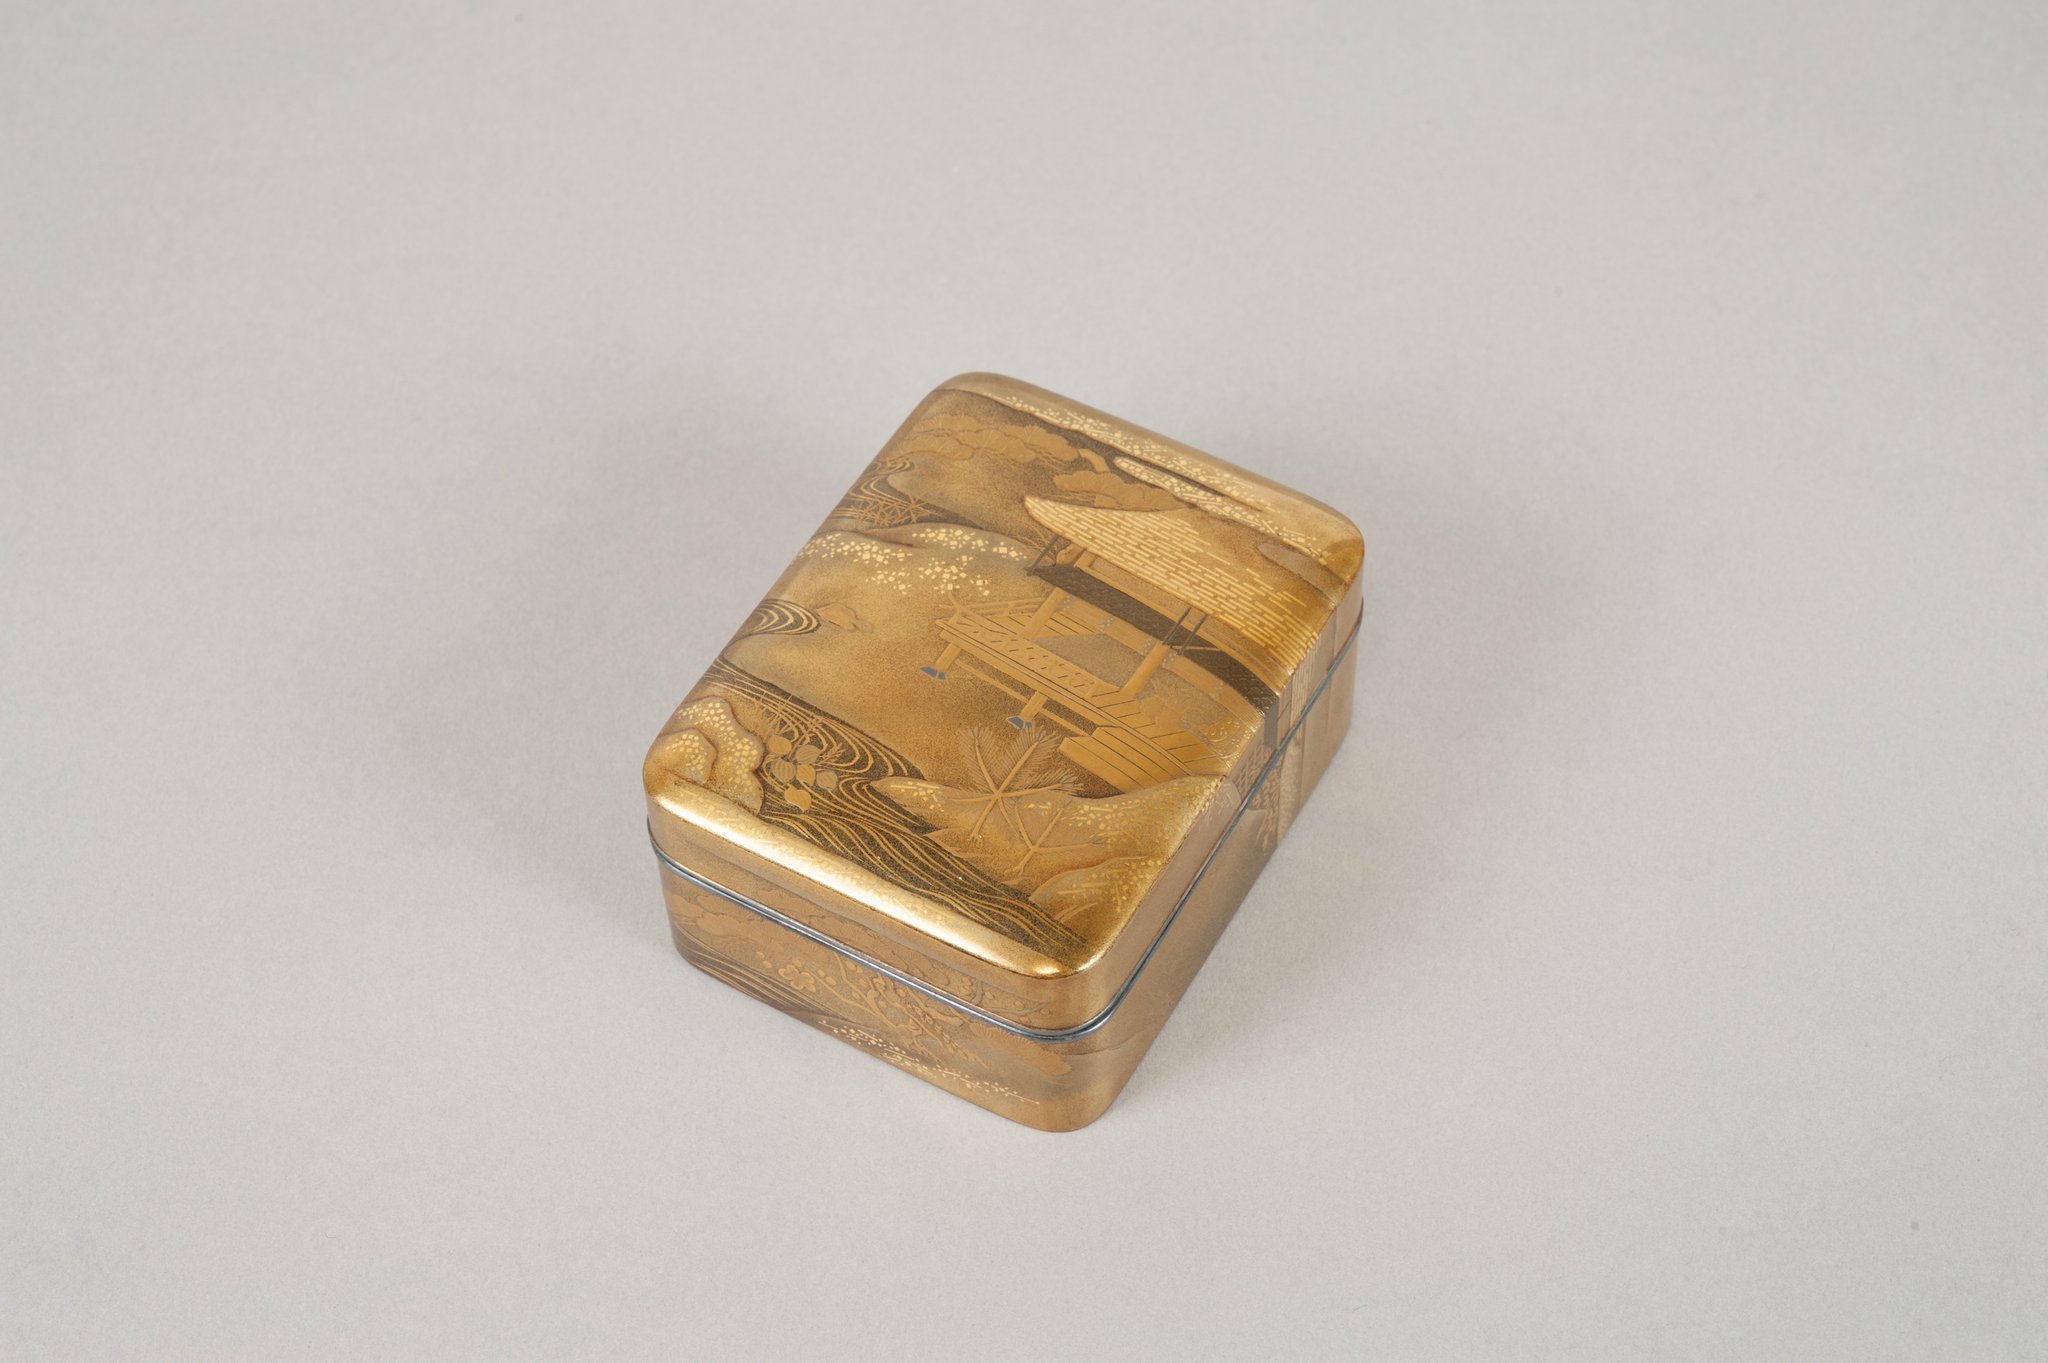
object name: incense container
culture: japanese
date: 1801-1900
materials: gold, lacquer, wood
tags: buildings